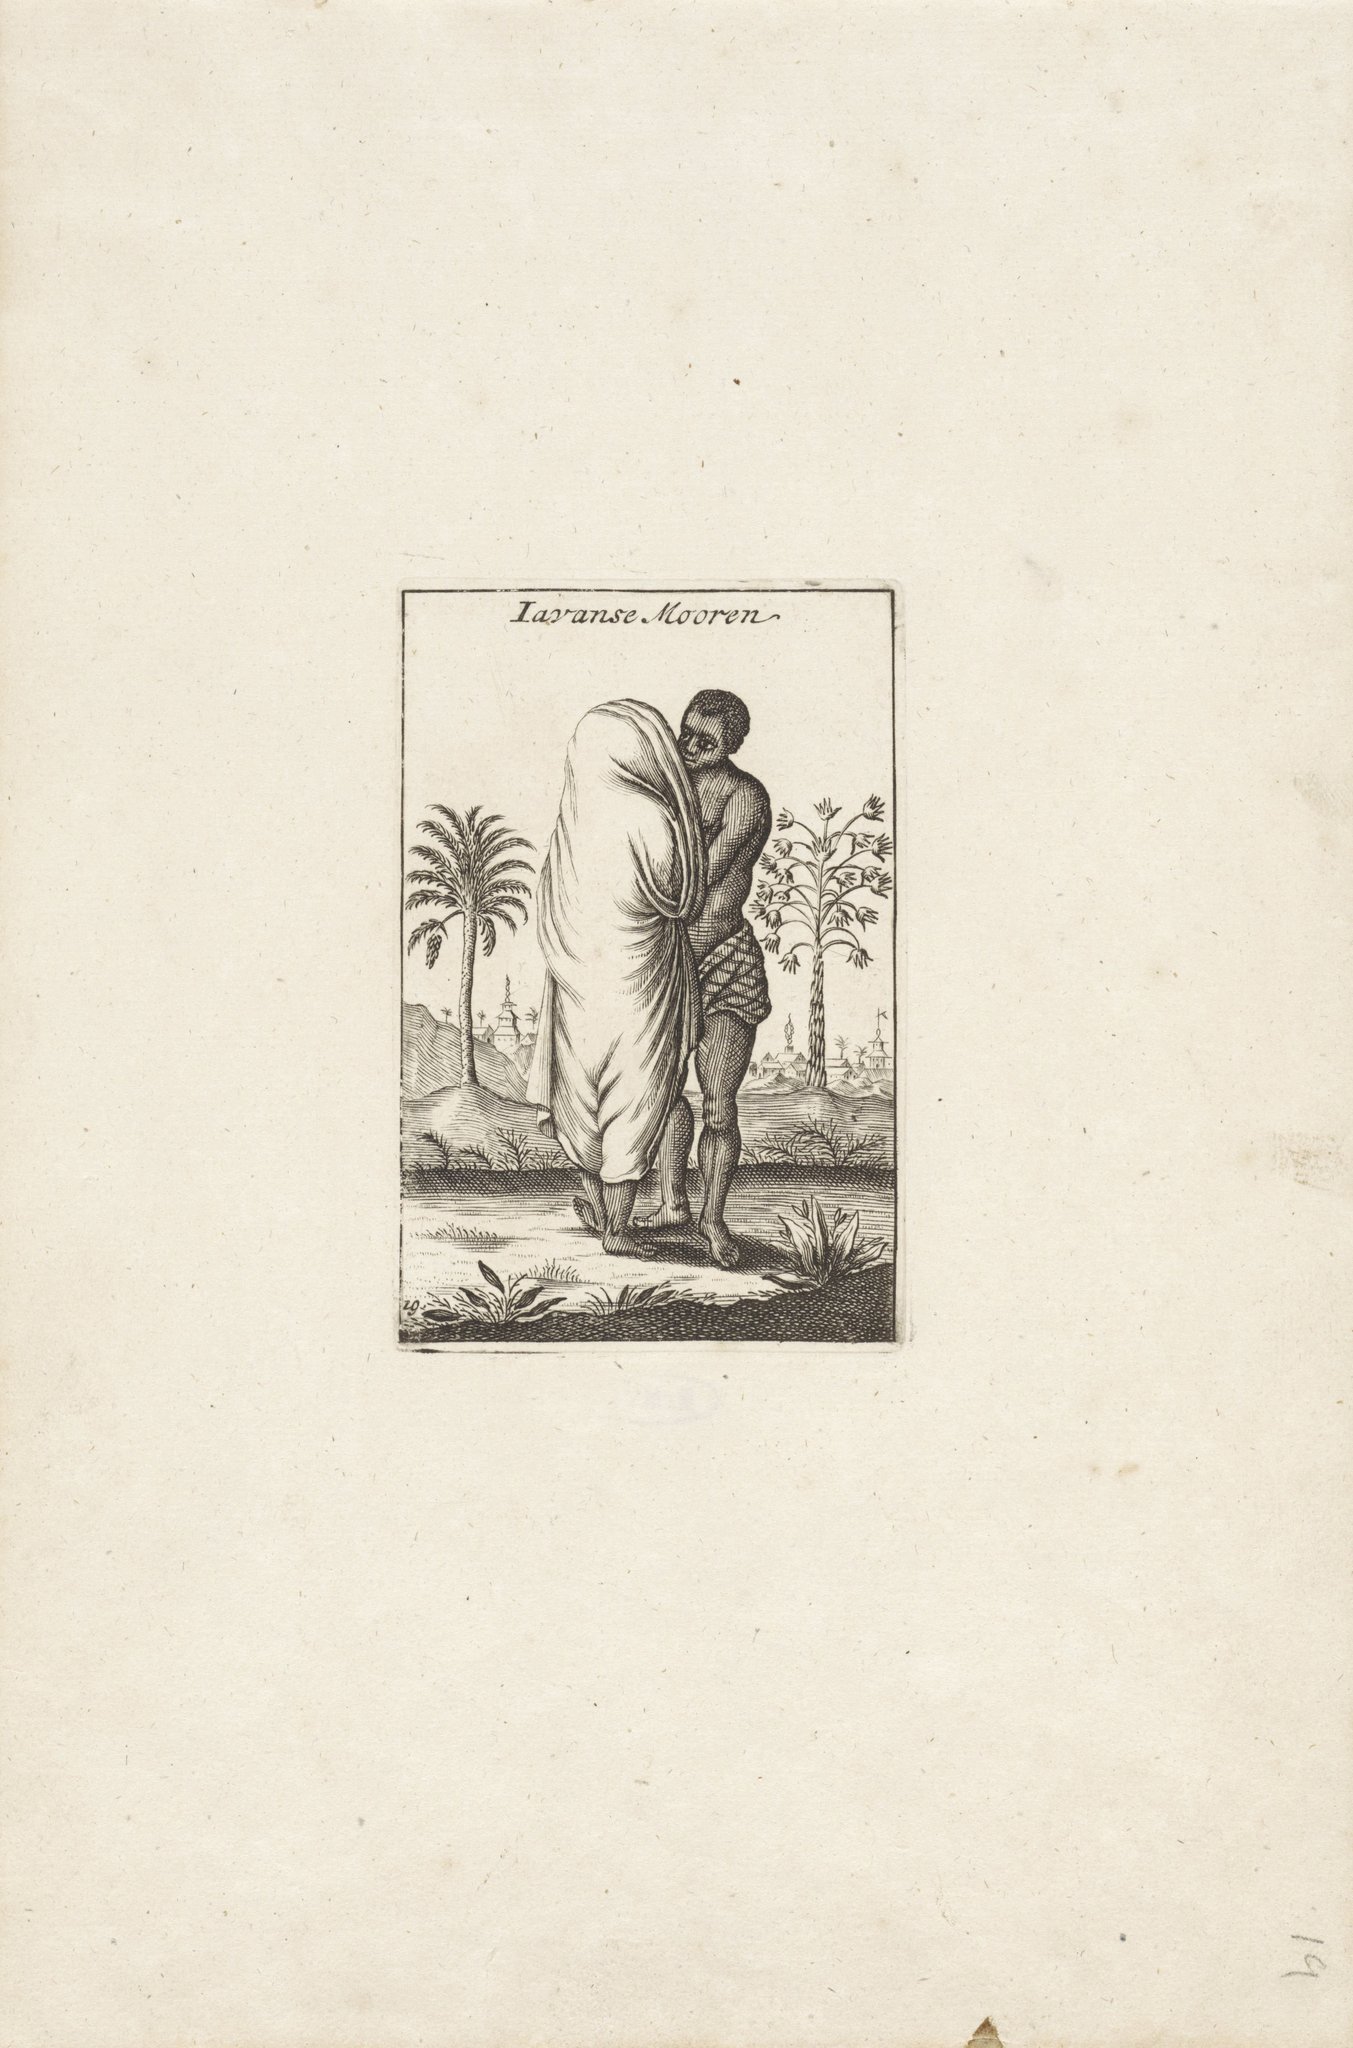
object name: print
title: Twee Javanen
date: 1682-1711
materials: paper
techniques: etching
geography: amsterdam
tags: asiatic races and peoples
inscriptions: collector's mark: Lugt 2228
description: Deze serie bestaat uit kopieën naar de prenten in: Vries, Simon de. Curieuse aenmerckingen der bysonderste Oost en West-Indische verwonderens-waerdige dingen. Utrecht: Johannes Ribbius, 1682.